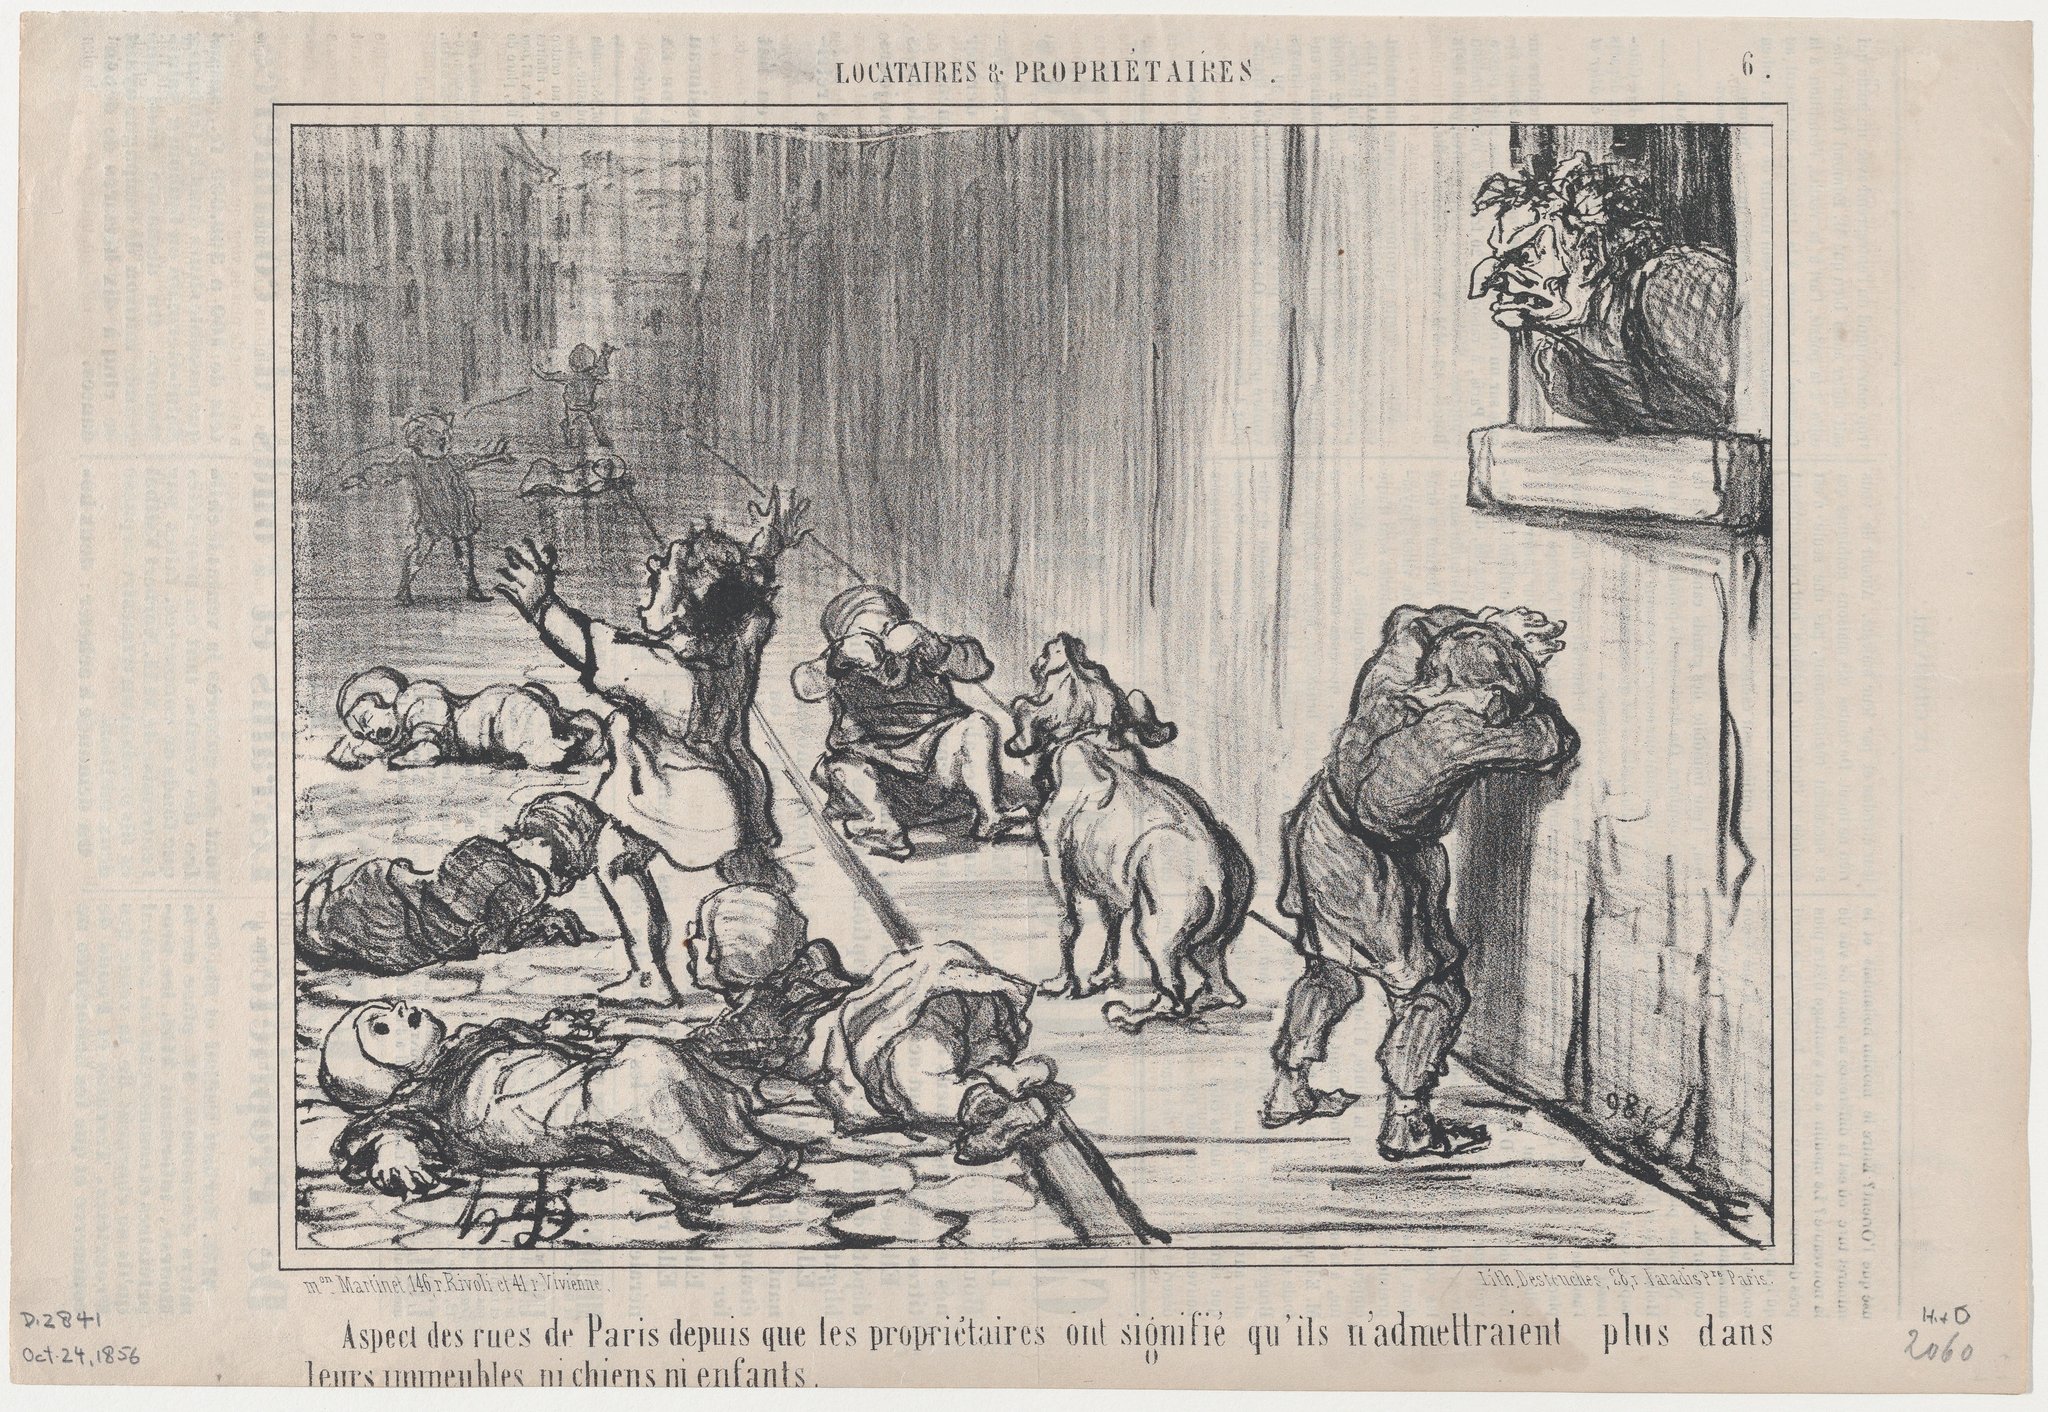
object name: print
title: Aspect des rues de Paris depuis..., from Locataires et Propiétaires, published in Le Charivari, October 24, 1856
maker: honoré daumier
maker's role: artist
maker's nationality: french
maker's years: 1808-1879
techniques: lithograph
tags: satire